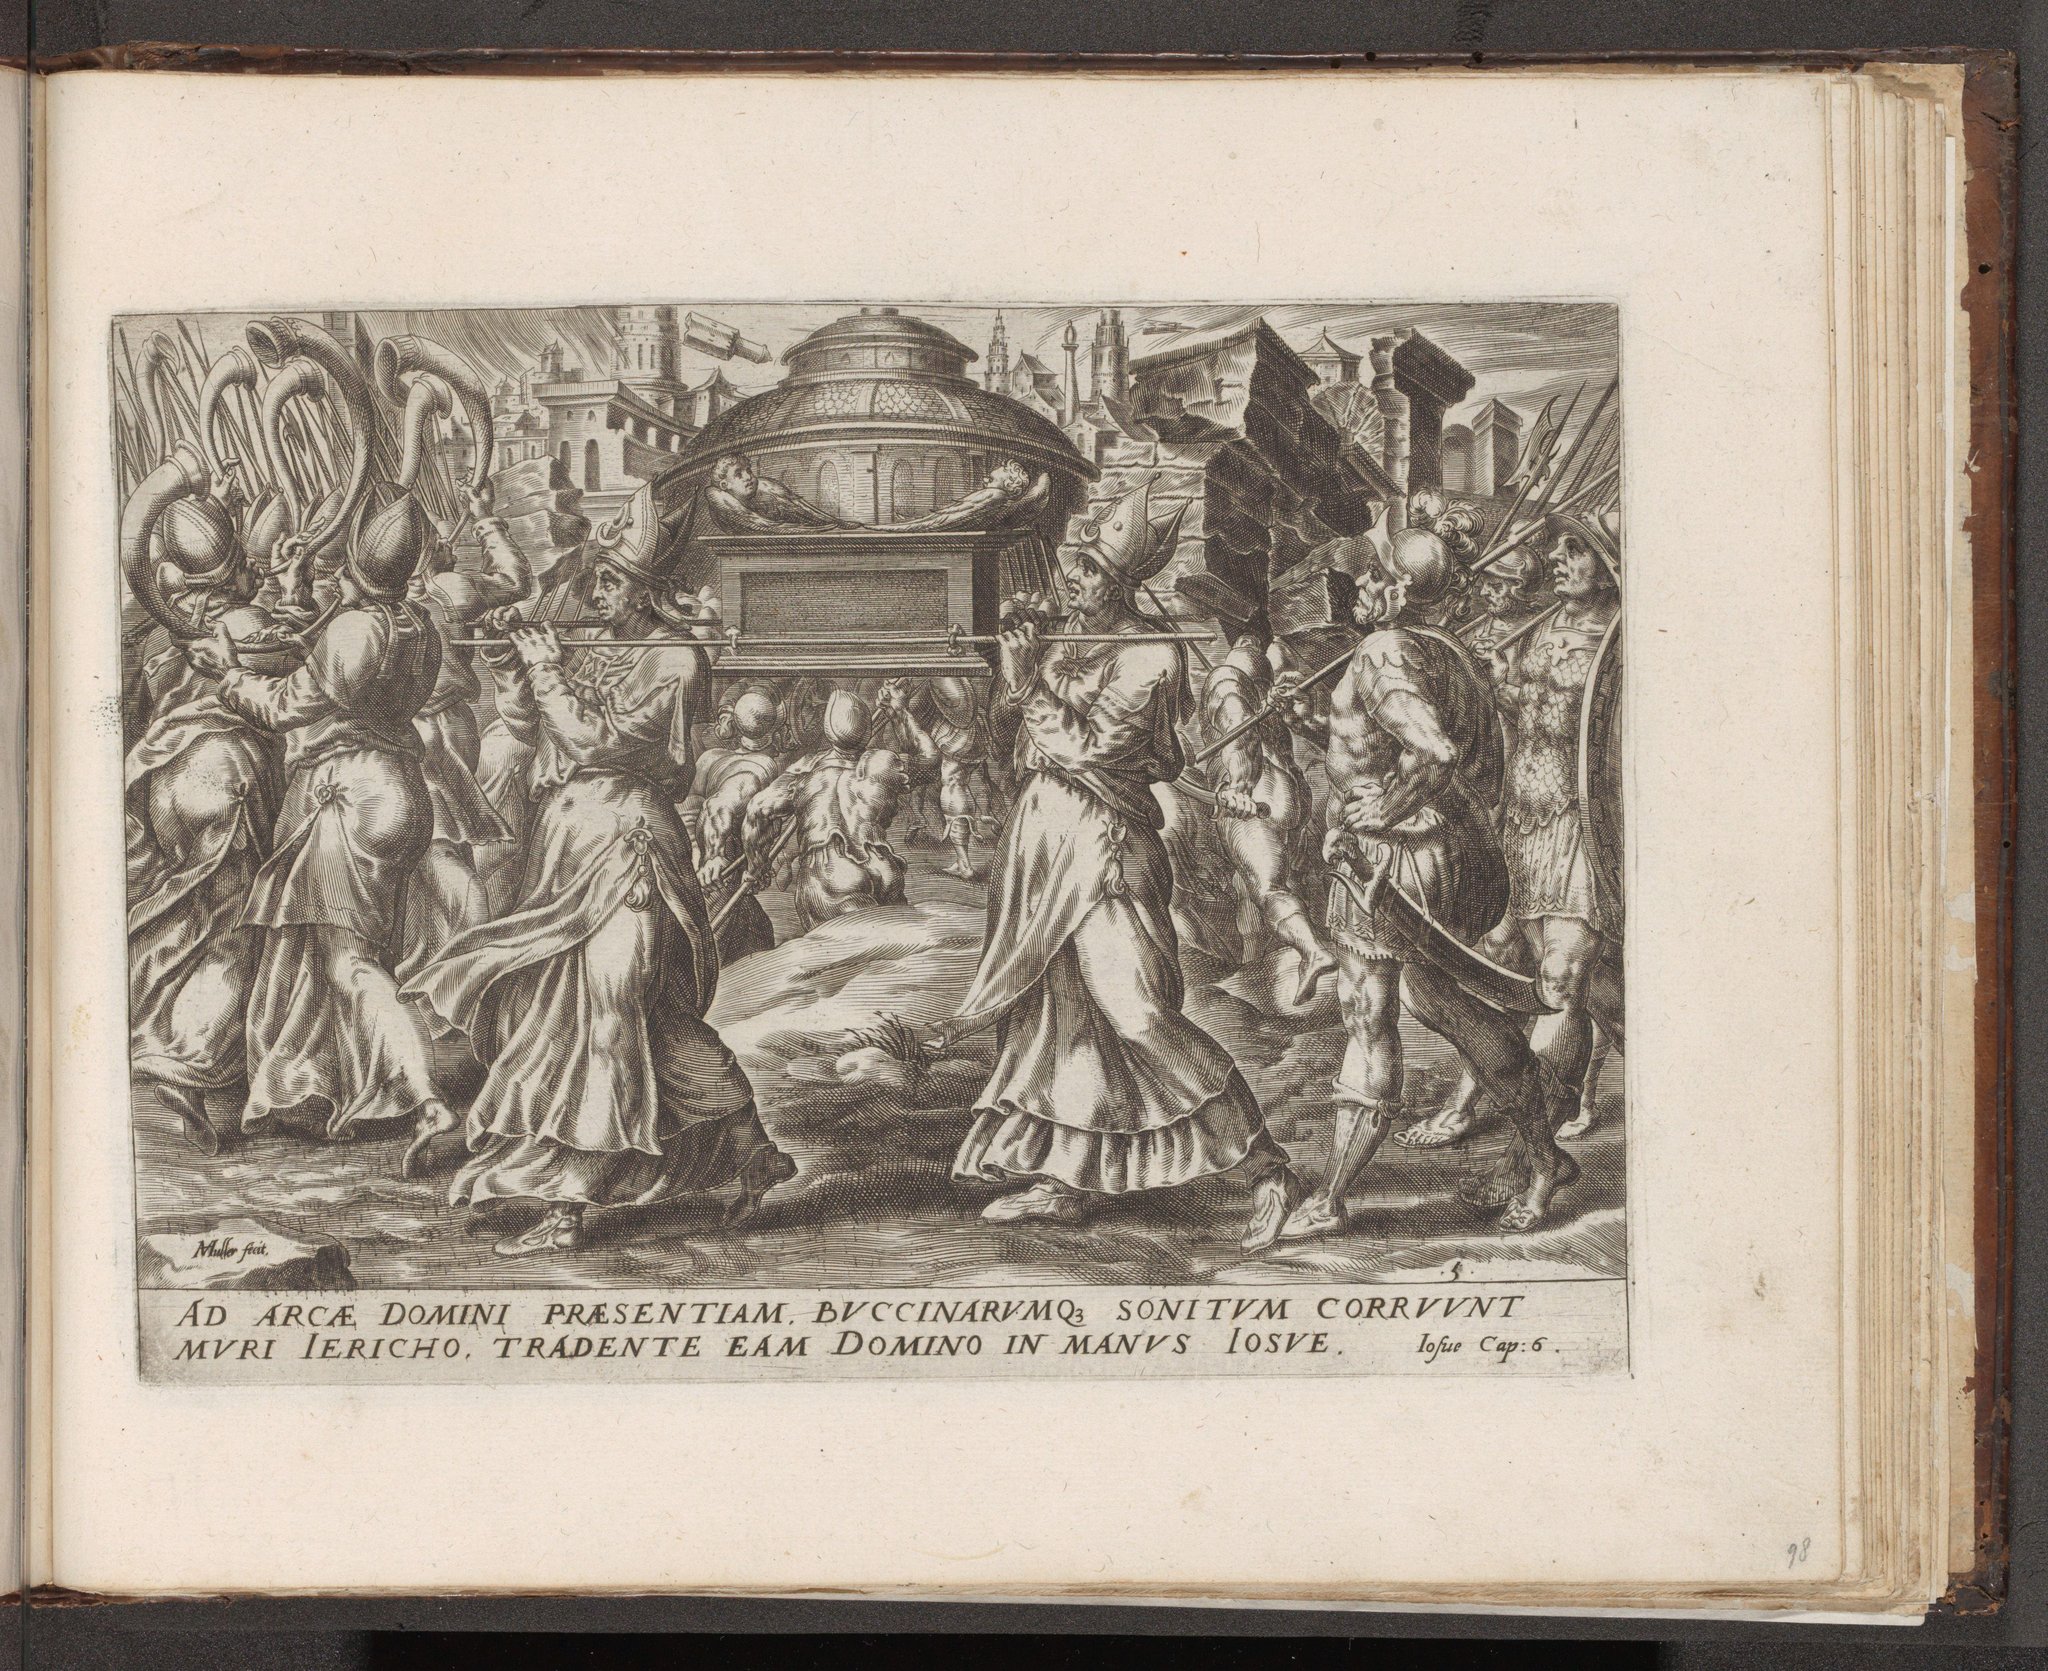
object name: album leaf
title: Val van Jericho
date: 1579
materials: paper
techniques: engraving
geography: antwerp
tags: on the seventh day, at a signal from joshua, the people start to shout and the walls of jericho crumble, the israelites march around jericho: in the procession the main body of the soldiers comes first, next are seven priests who blow on trumpets, followed by the priests carrying the ark and a rear guard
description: Zeven priesters blazen op hun ramshorens, terwijl ze voor de ark van het verbond uit lopen. De muren van de stad Jericho storten in en het volk bestormt de stad. Onder de voorstelling een verwijzing in het Latijn naar de Bijbeltekst in Joz. 6. Prent maakt deel uit van een album.